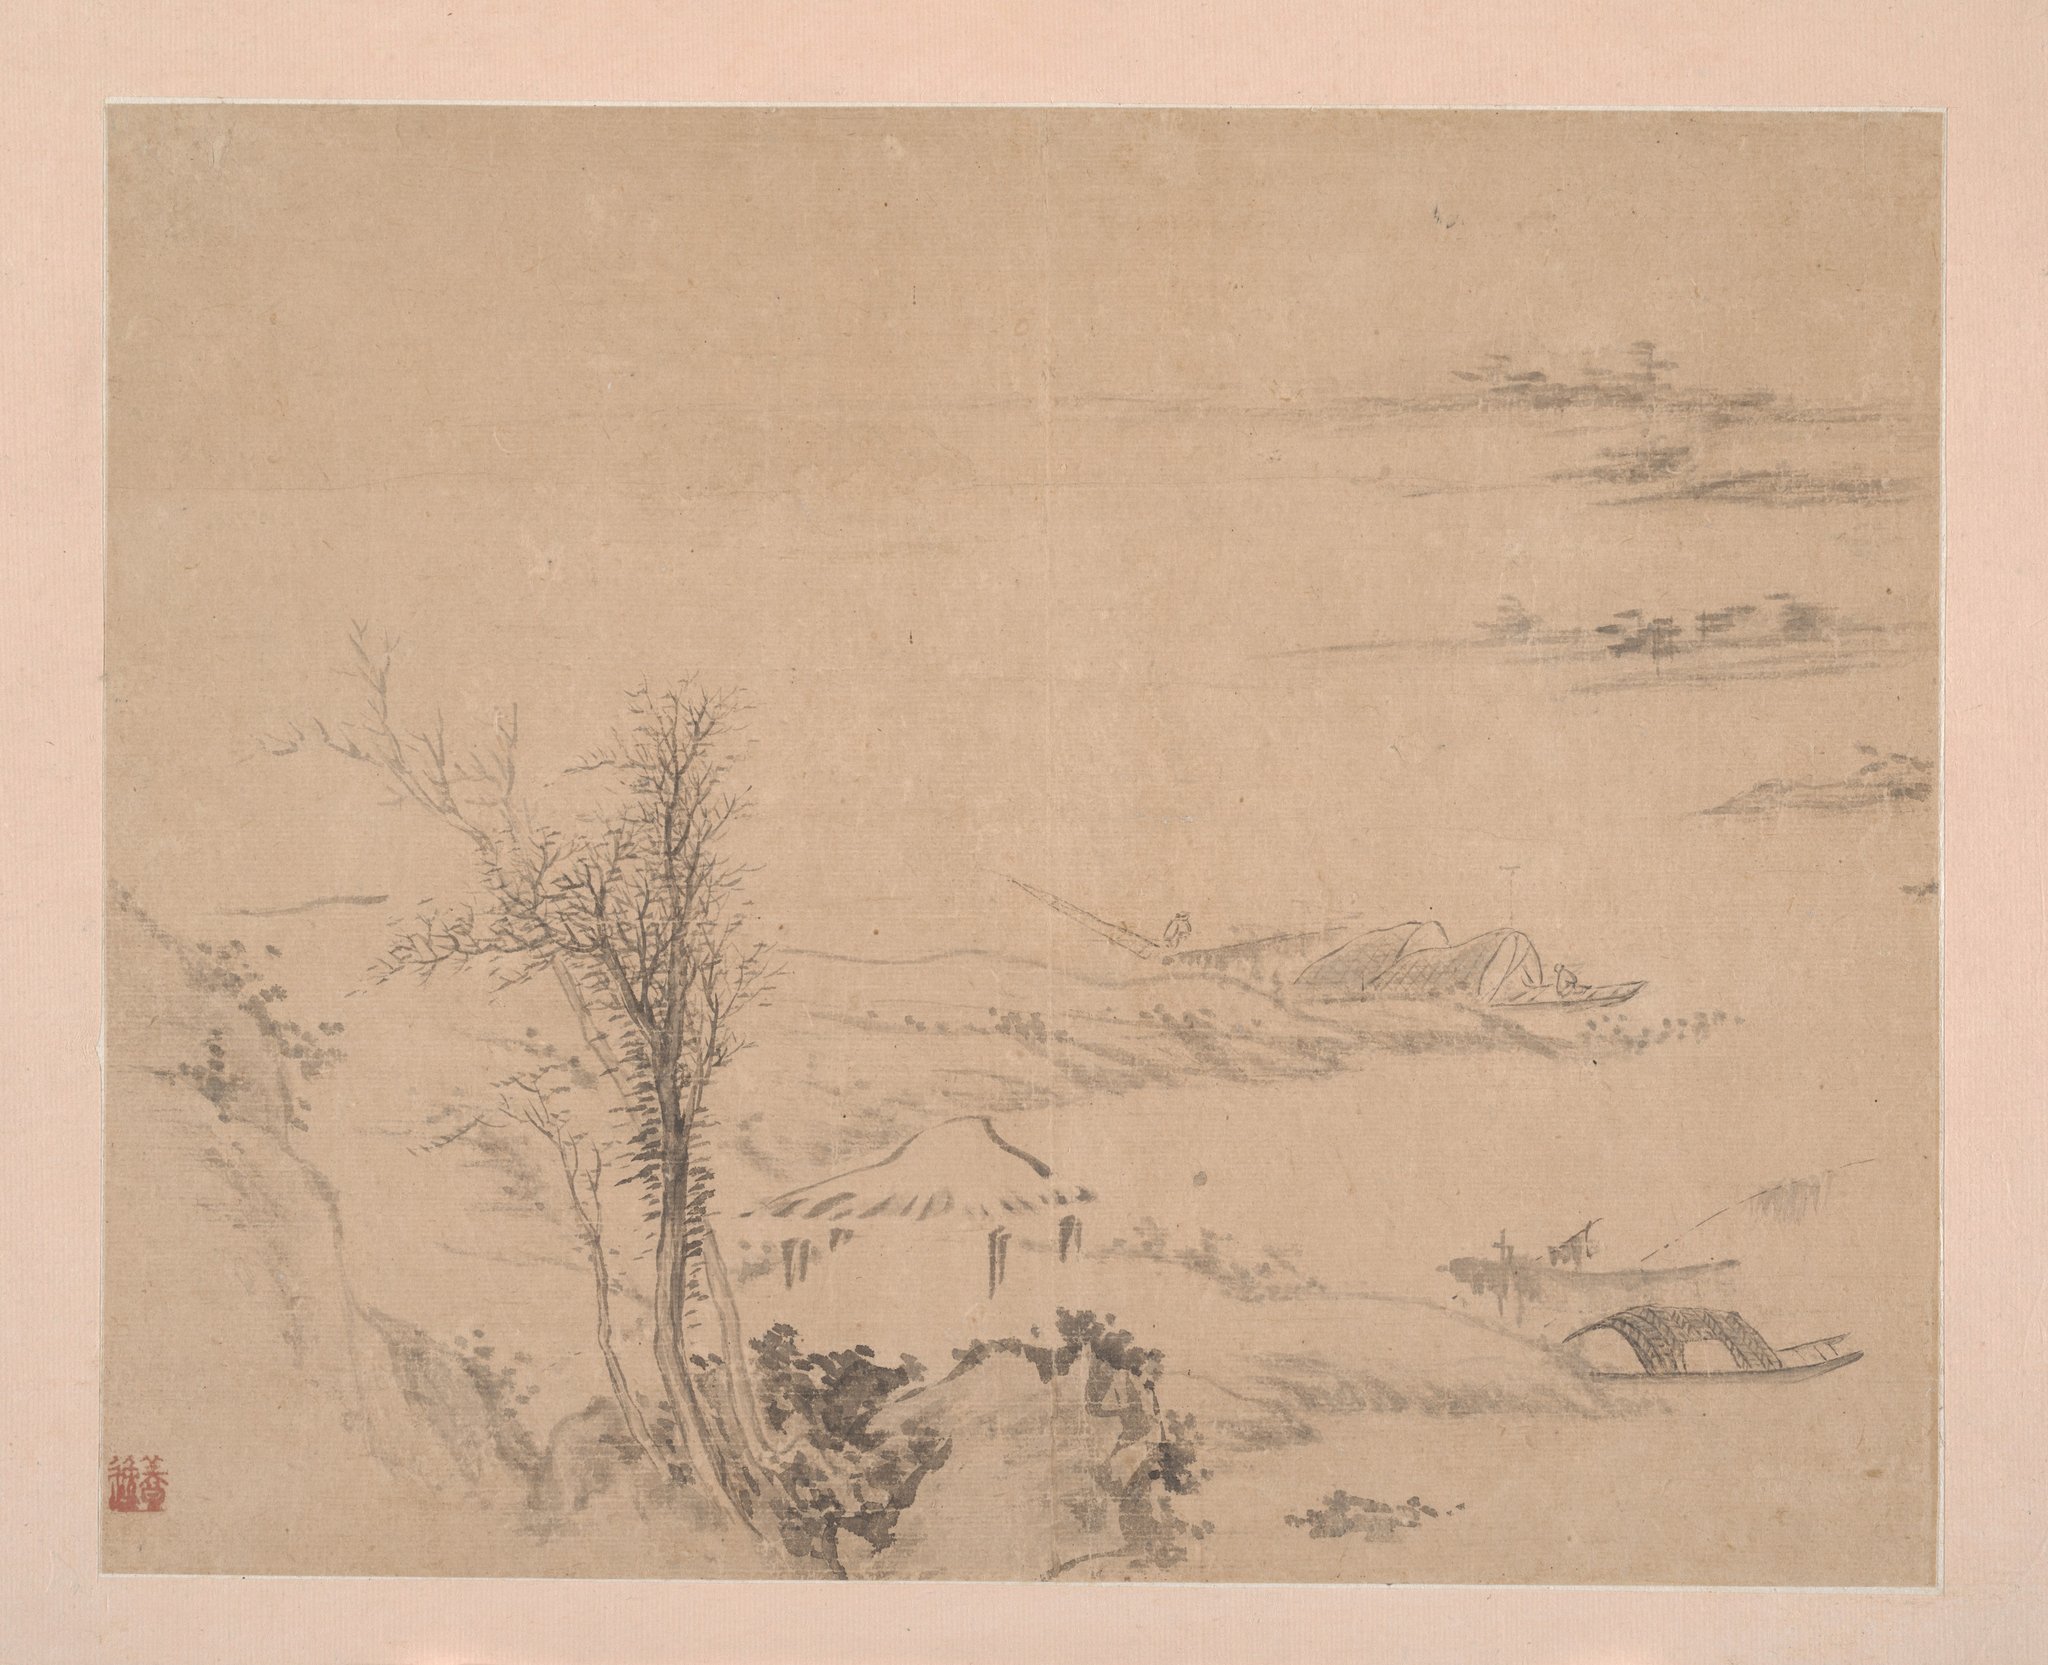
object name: album leaf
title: River Scene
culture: chinese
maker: unidentified artist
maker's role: artist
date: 1644-1911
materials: ink, silk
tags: rivers,landscapes,boats